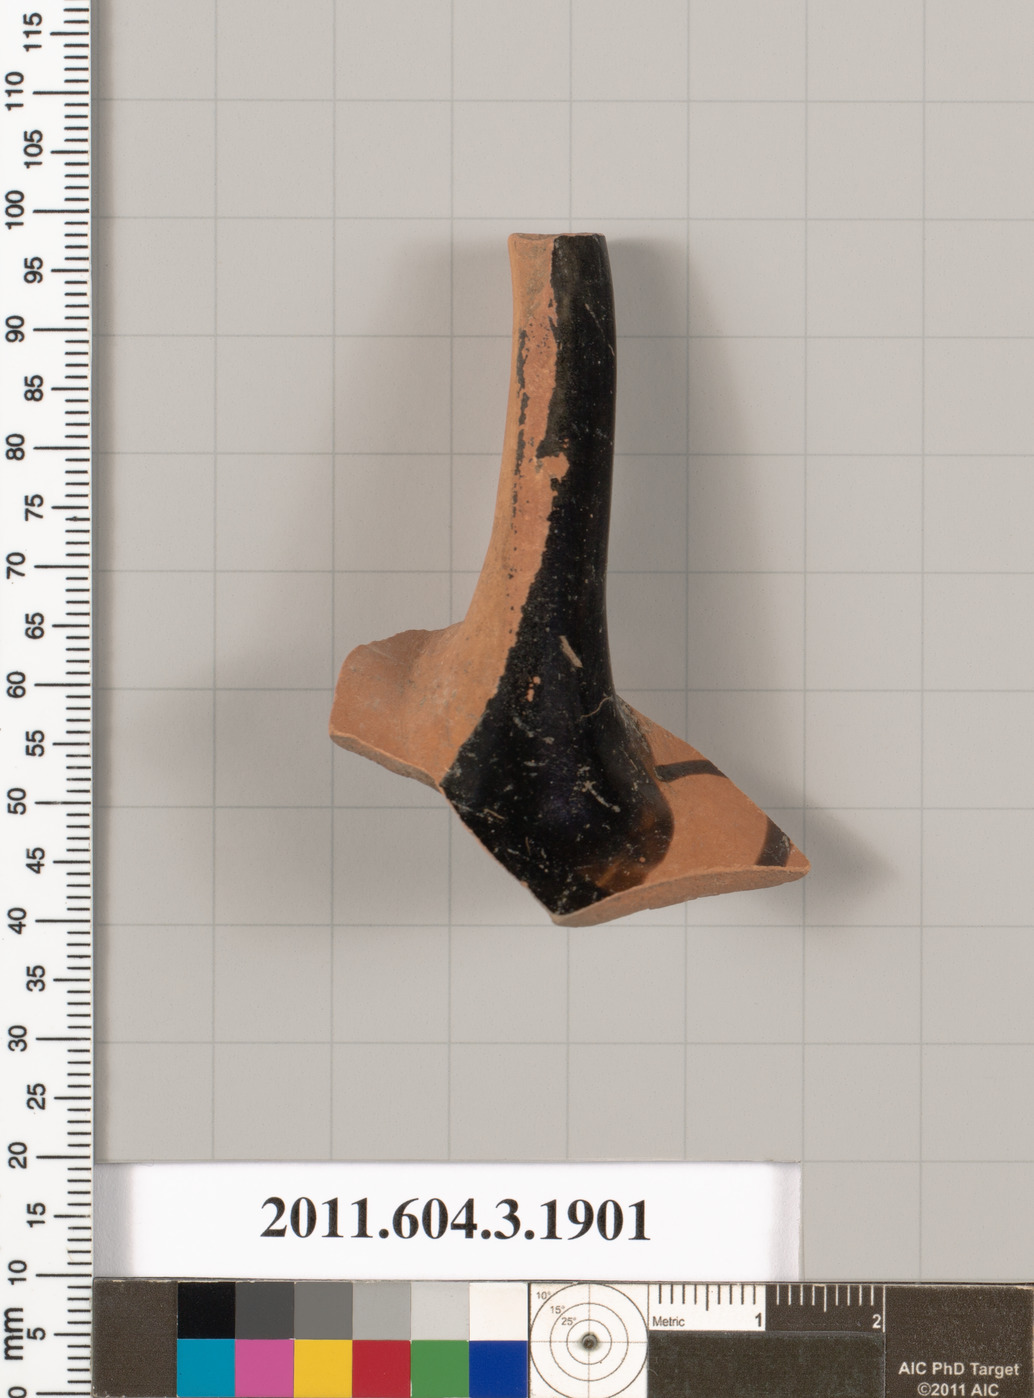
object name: kylix fragment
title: Terracotta fragment of a kylix (drinking cup)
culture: greek, attic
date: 600-401 BCE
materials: terracotta